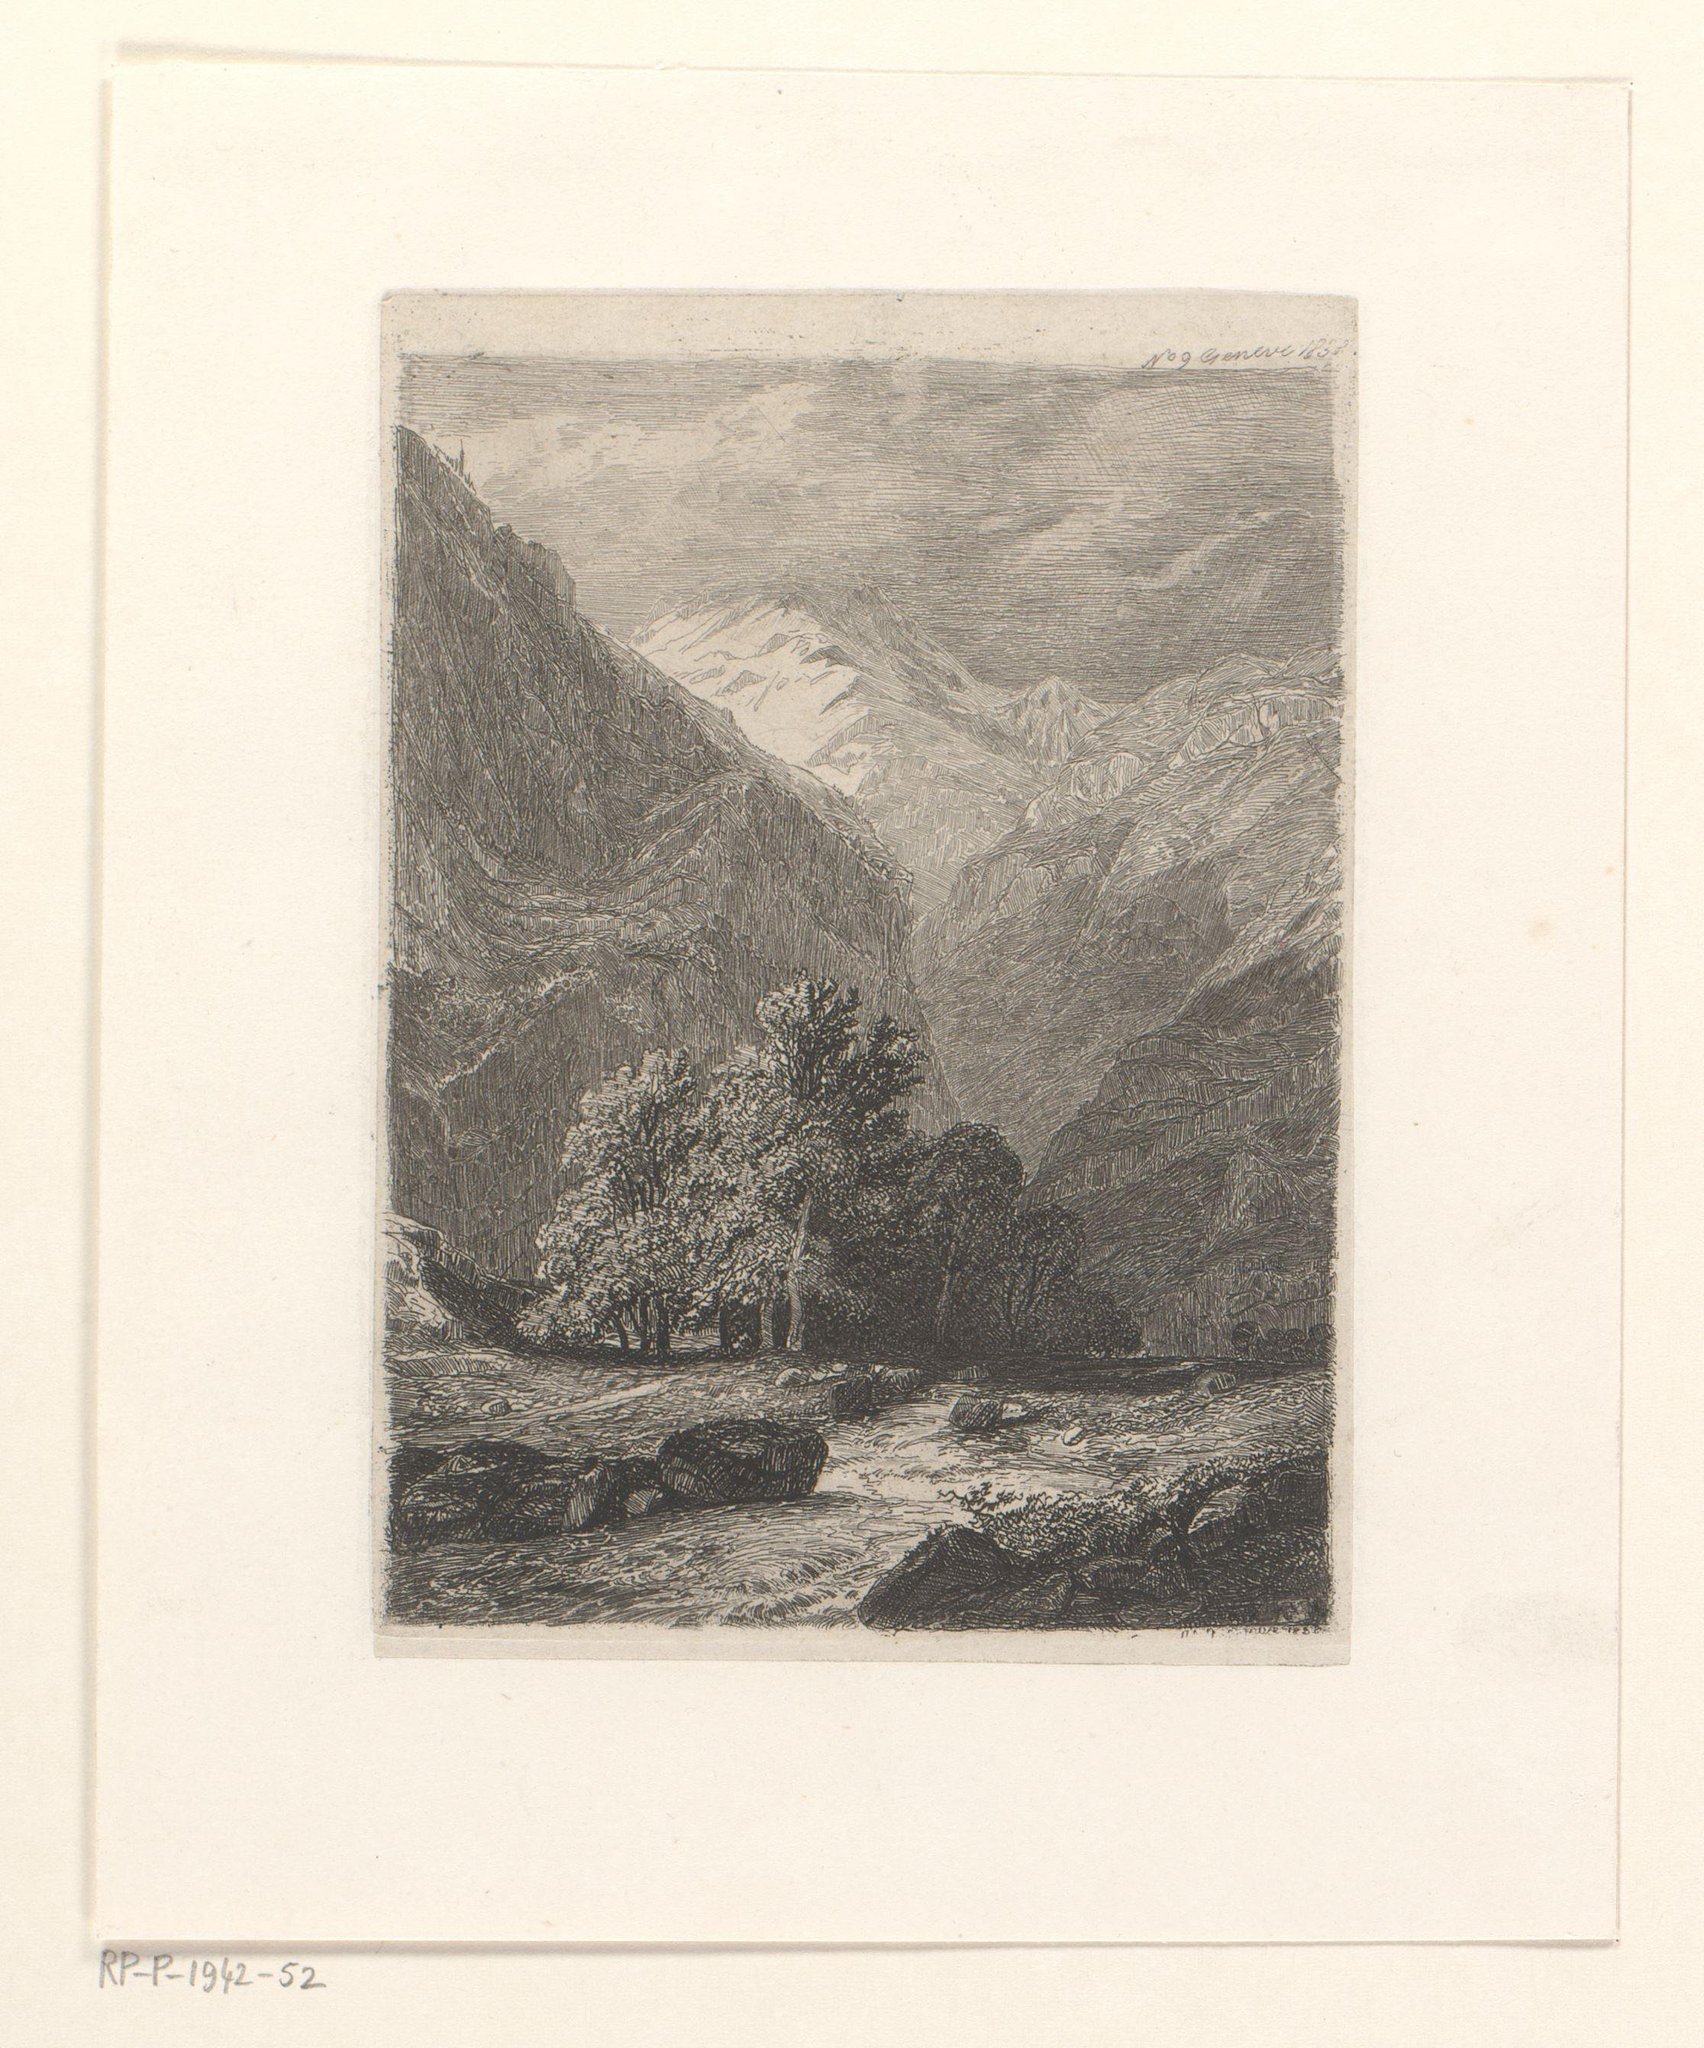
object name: print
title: Essais de gravure a l'eau forte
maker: alexandre calame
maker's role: draughtsman, painter, print maker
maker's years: 1810-1864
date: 1838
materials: paper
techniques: etching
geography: geneva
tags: dale, valley, trees, mountains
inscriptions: collector's mark: Lugt 2760, collector's mark: Lugt 2228